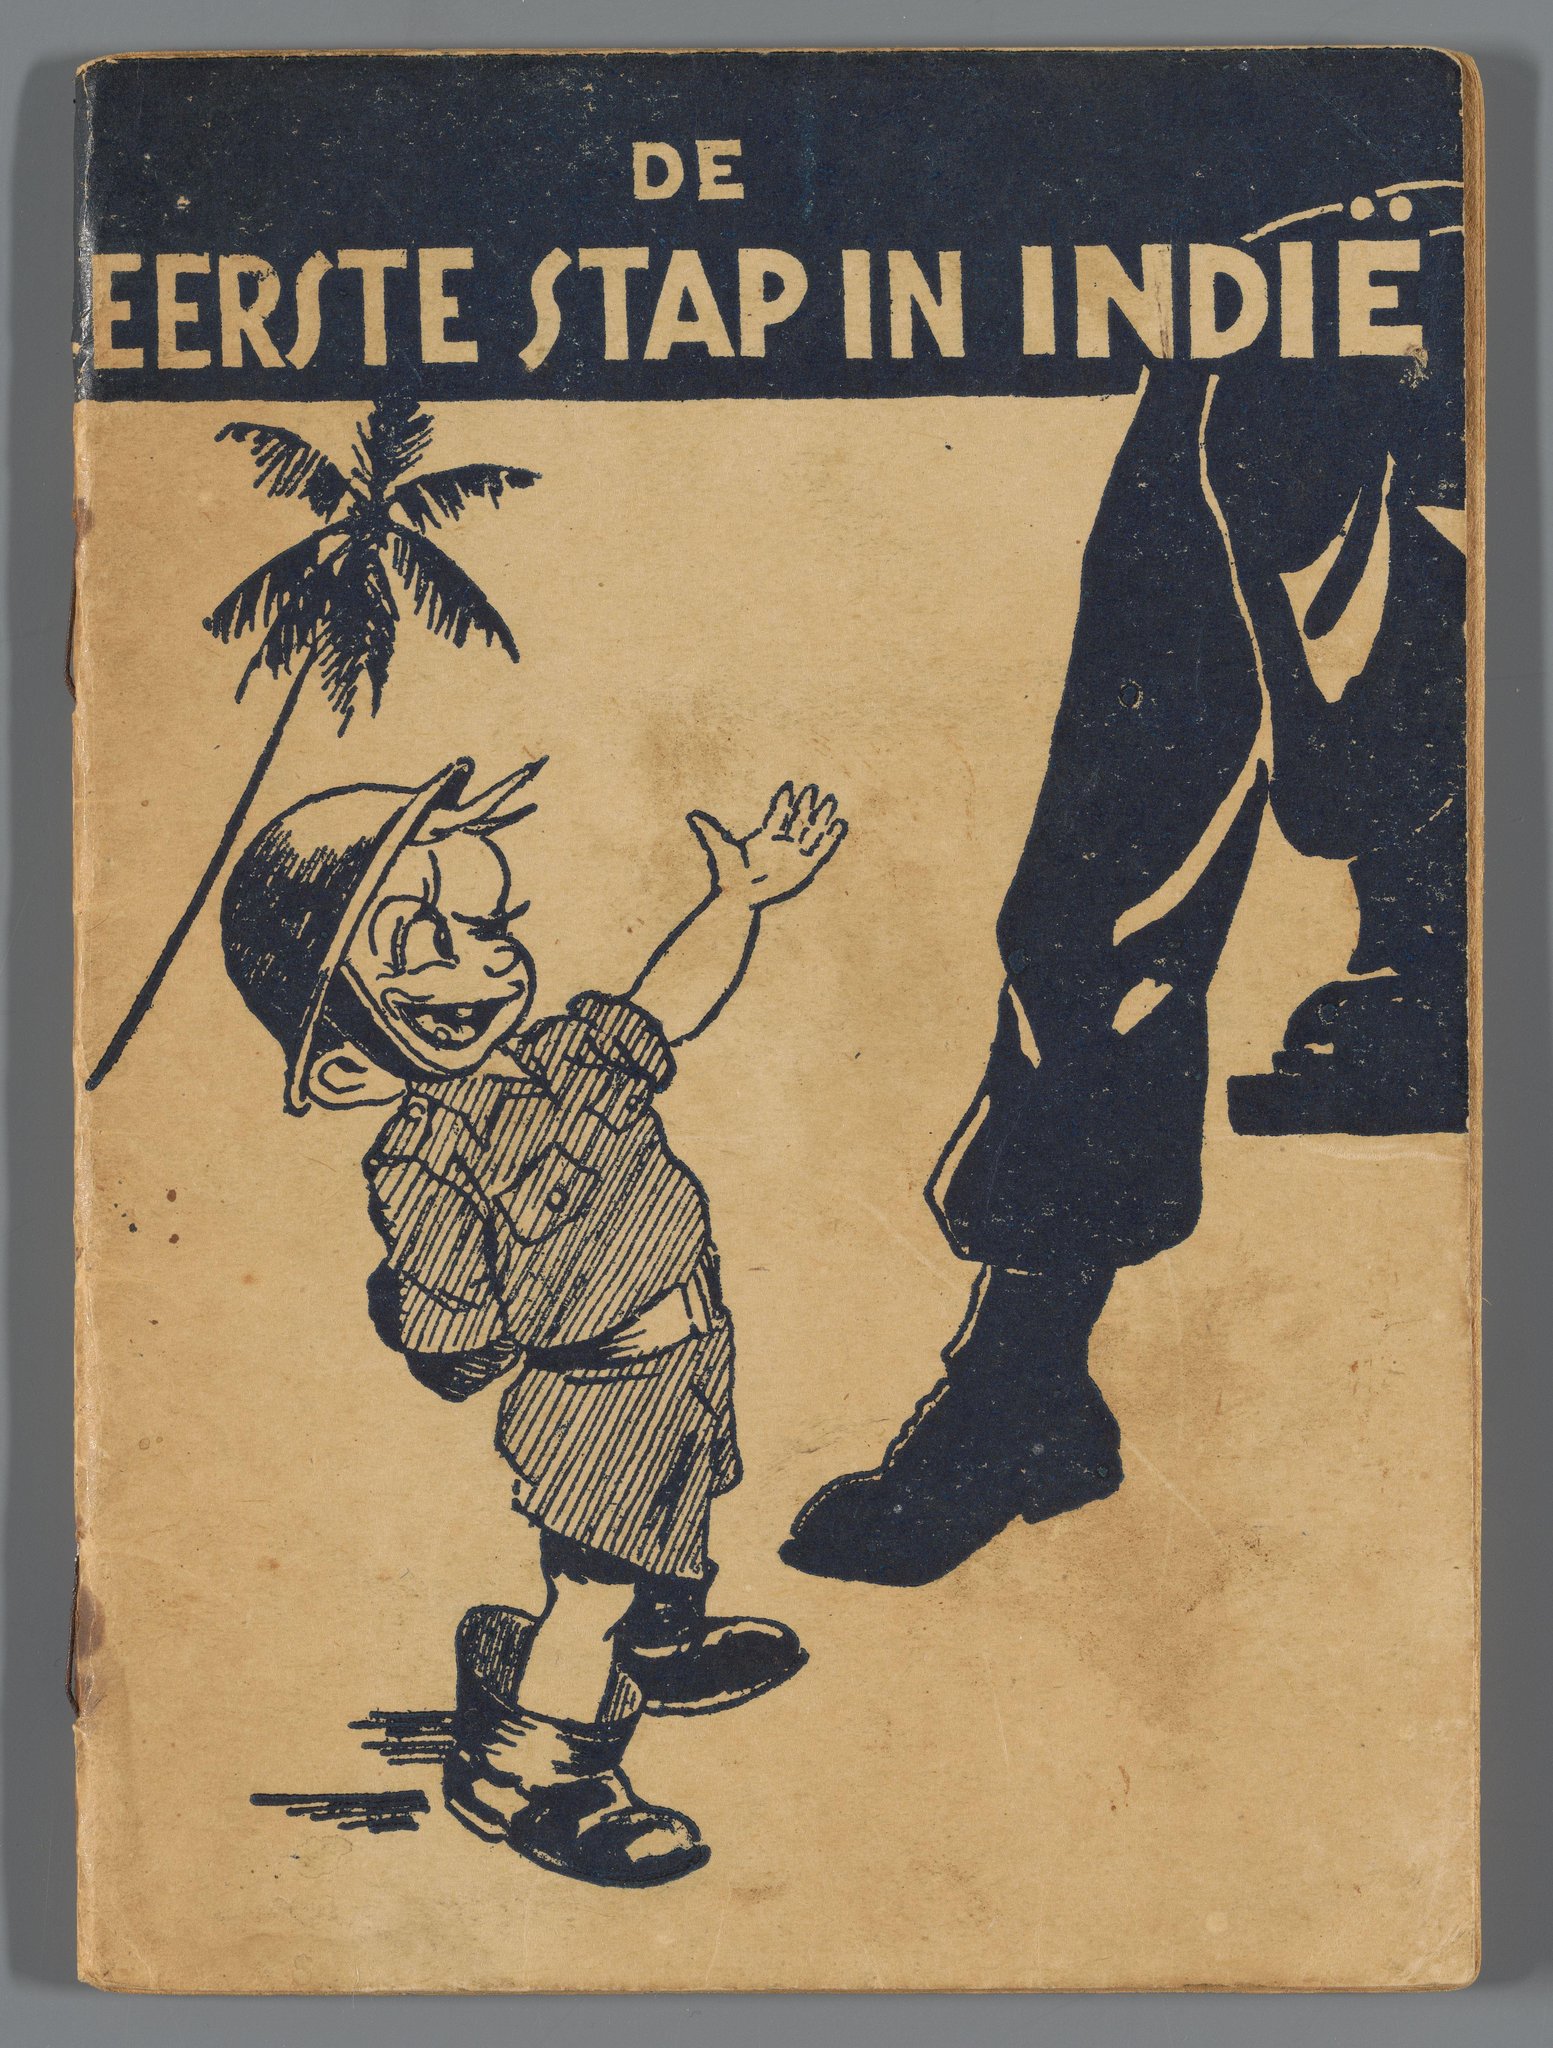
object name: brochure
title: Brochure over de Nederlandse troepen die na 1945 in Indonesië (terug)komen. 'De eerste stap in Indië'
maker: visser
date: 1945-1946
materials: paper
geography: jakarta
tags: military service, indonesia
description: Boekje met illustraties en uitvouwbare kaart van Batavia met instructietekst voor aankomende soldaten. Waarschuwing tegen prostituees en drank. 15 pagina's. Door: 'Wimpey Welfare'. Kaft: zwartwit opdruk van een kleuter-soldaat die schuilt bij de benen van een grote soldaat.